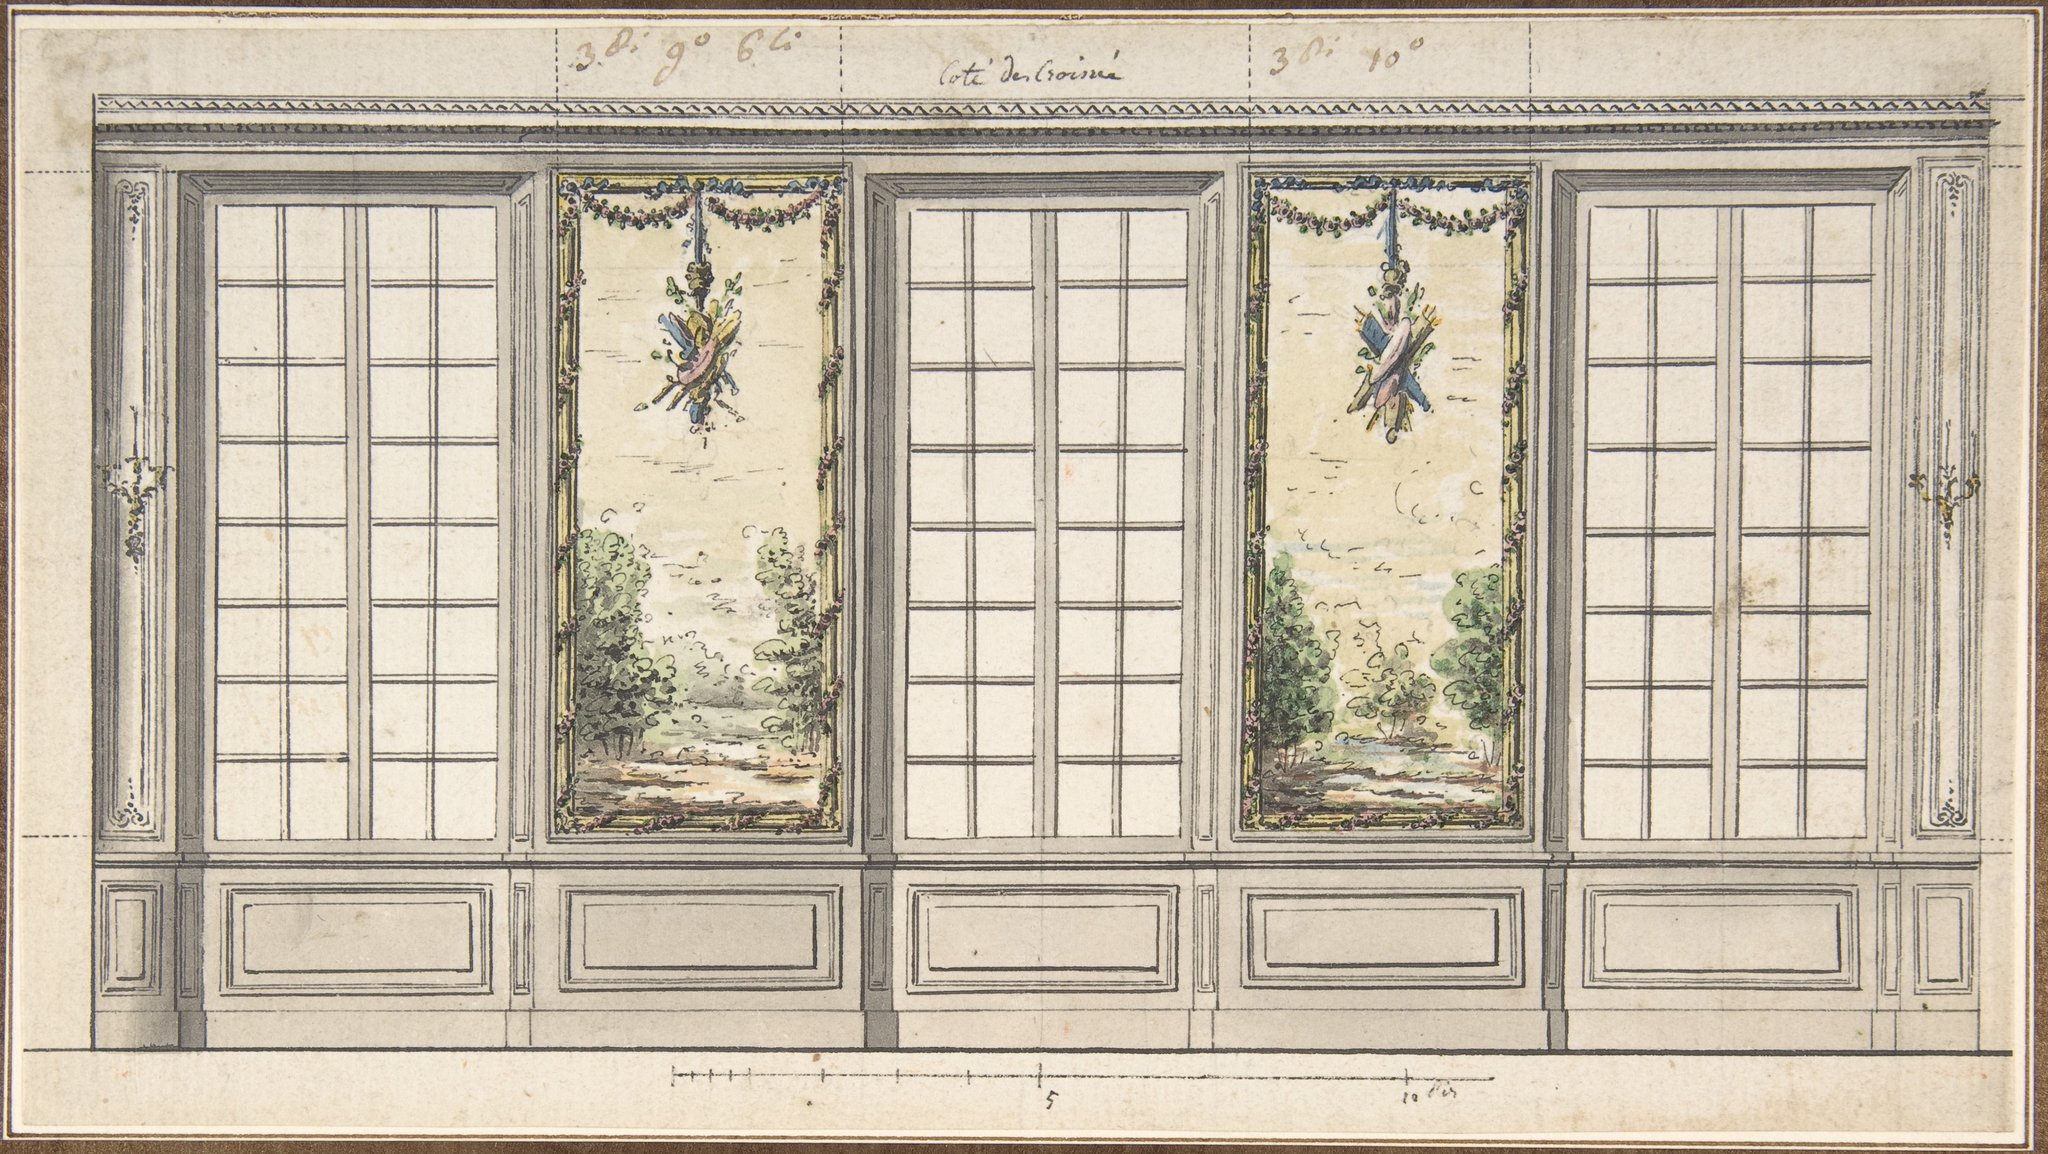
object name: drawing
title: Design for a Windowed Wall with Decorative Panels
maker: anonymous, french, 18th century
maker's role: artist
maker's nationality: french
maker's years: 1700-1800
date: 1734-1766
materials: graphite, ink, watercolor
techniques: brush, pen, wash